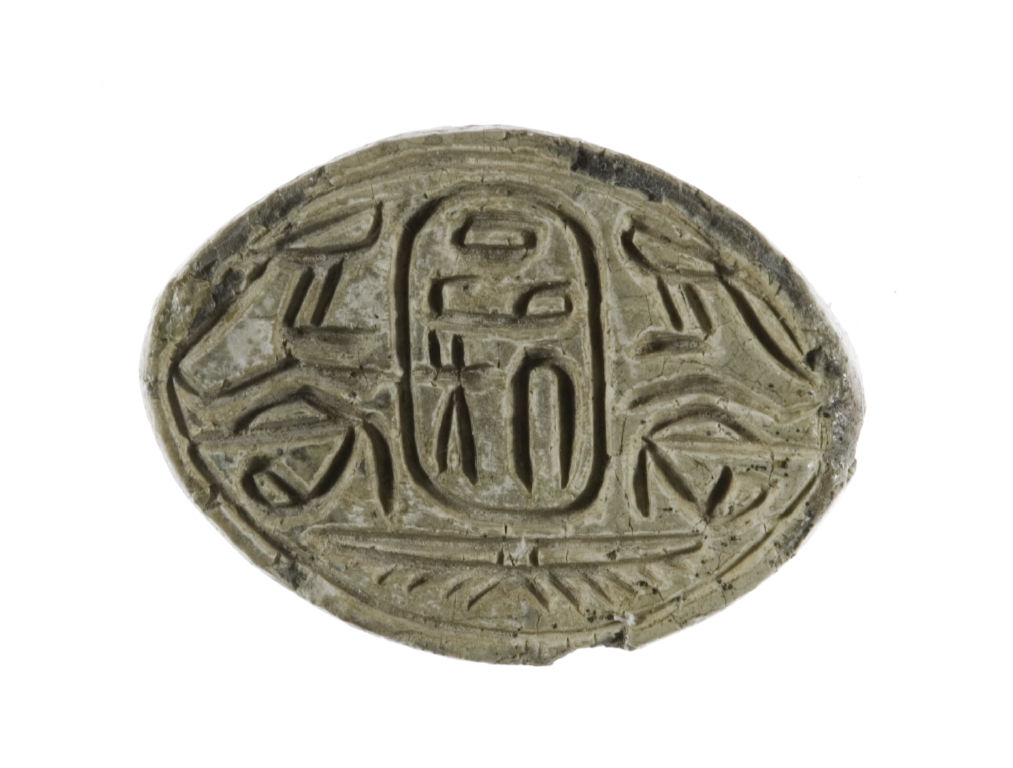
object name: cowroid, auserre apophis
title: Cowroid Seal Amulet with the Name of the Hyksos King Apophis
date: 1581-1541 BCE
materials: glaze, stone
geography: egypt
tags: hieroglyphs